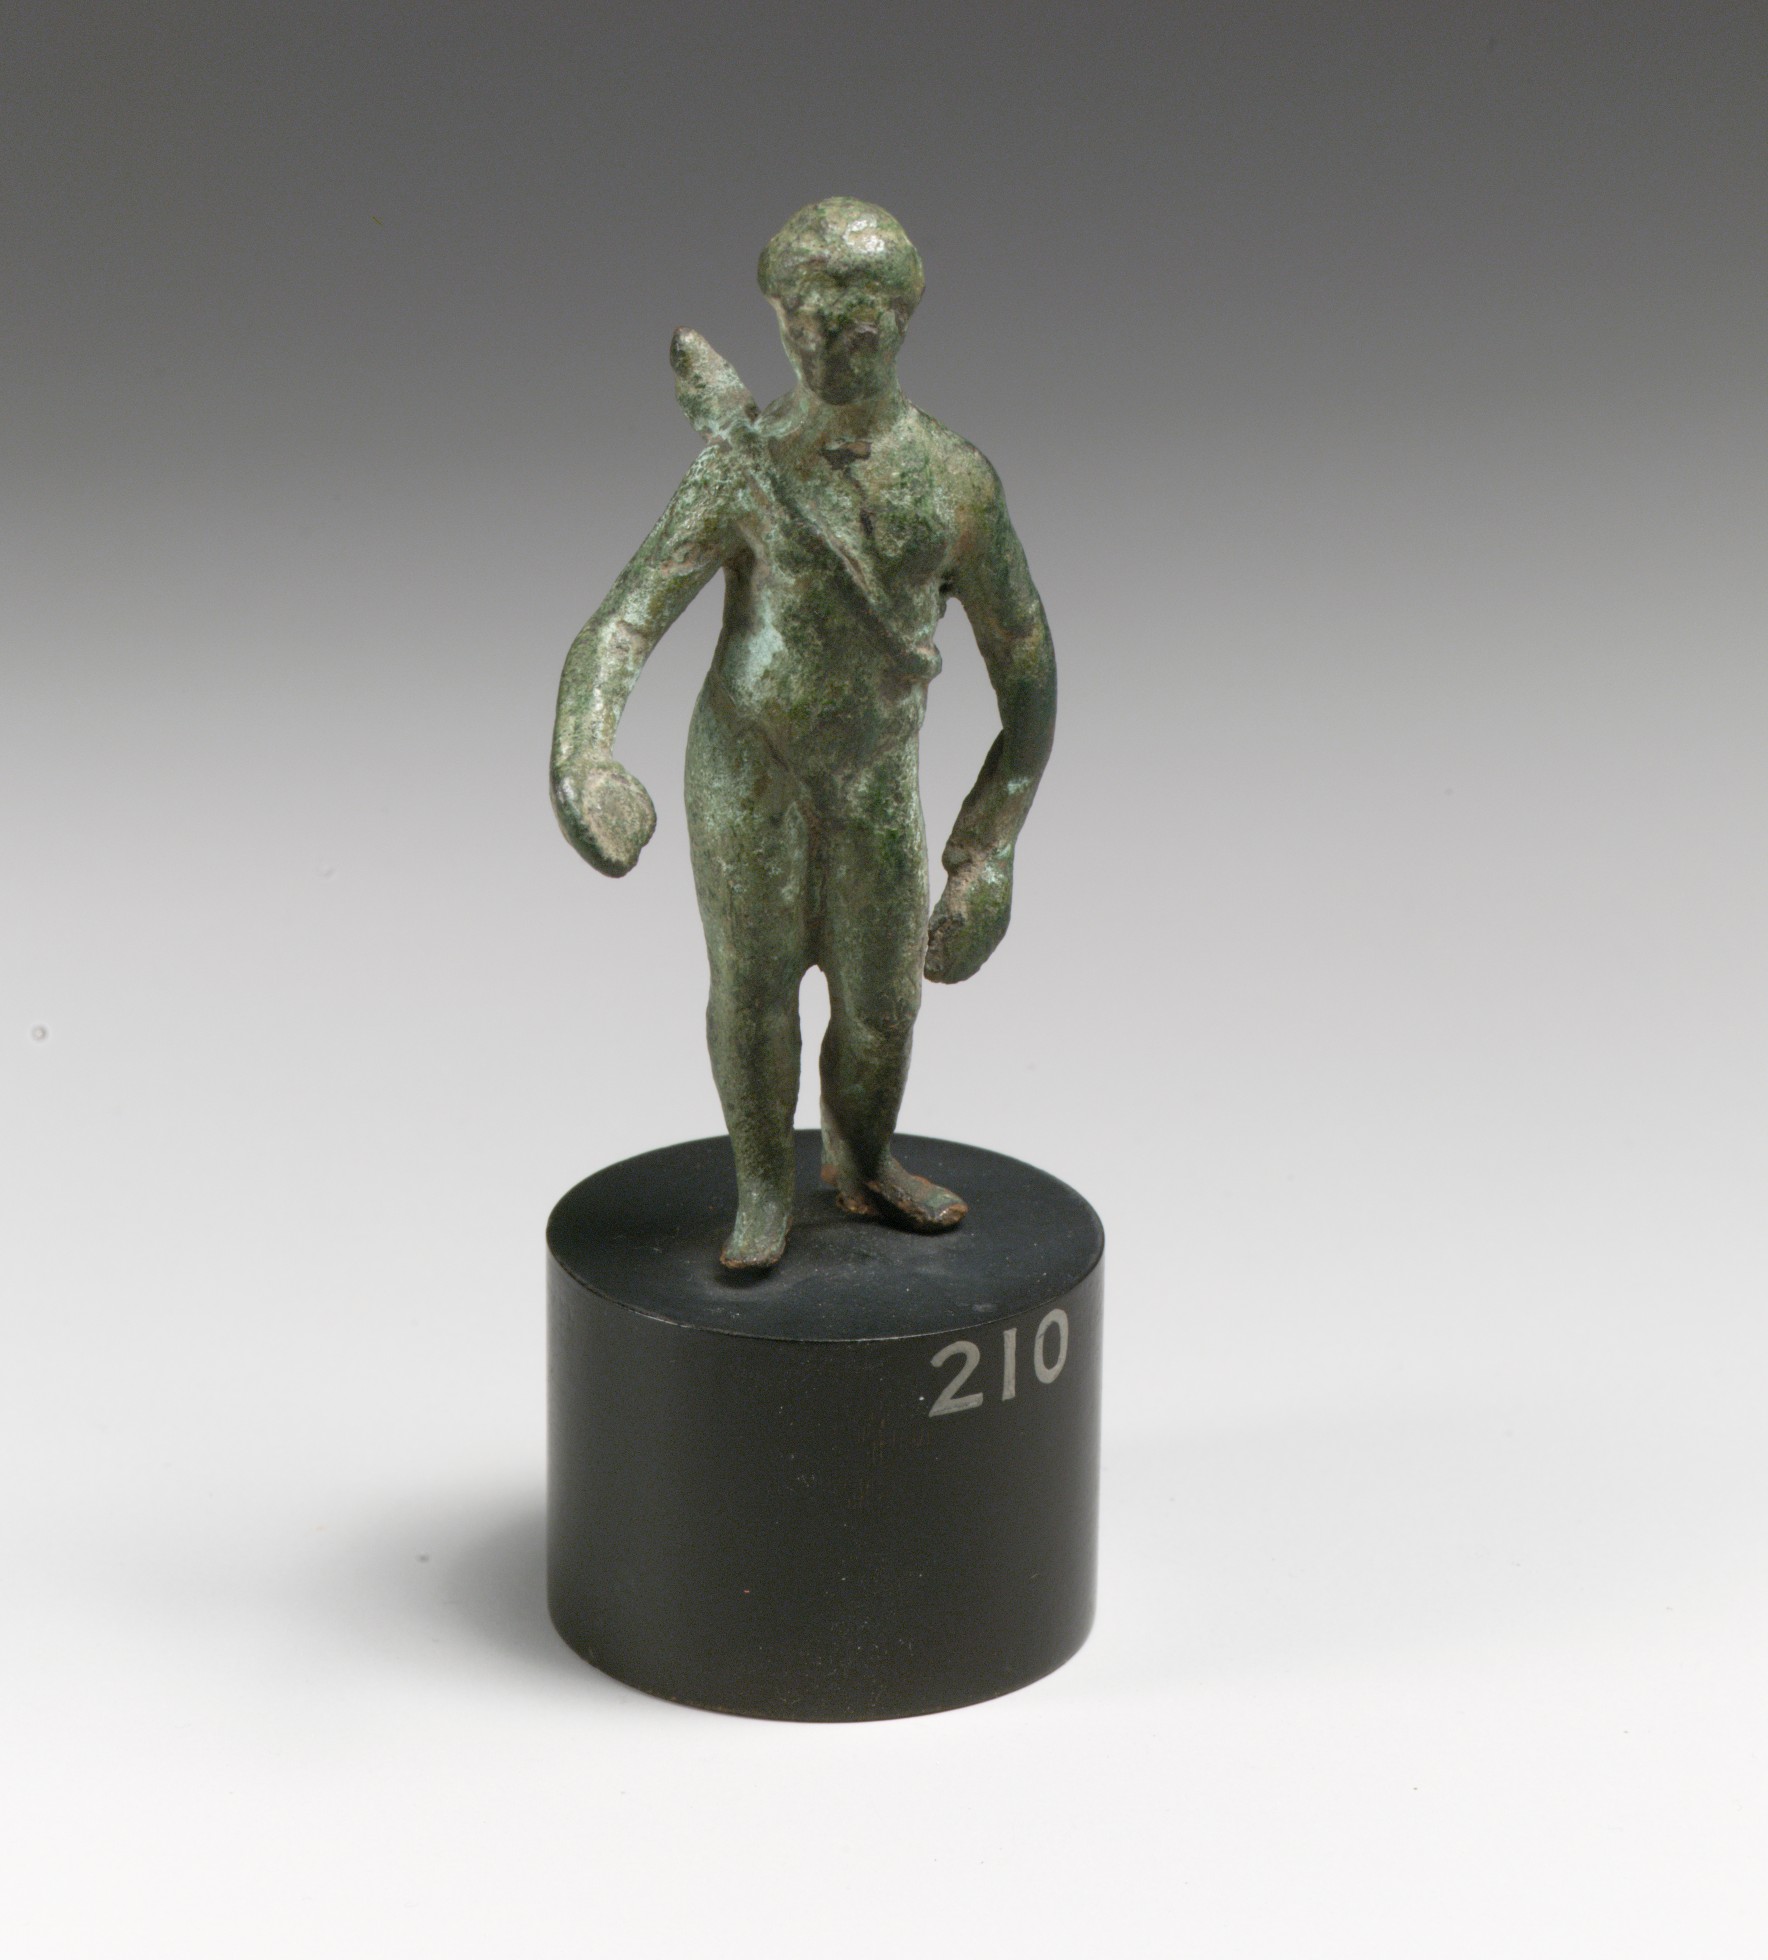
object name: statuette of apollo with quiver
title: Bronze statuette of Apollo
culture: roman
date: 1-200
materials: bronze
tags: apollo